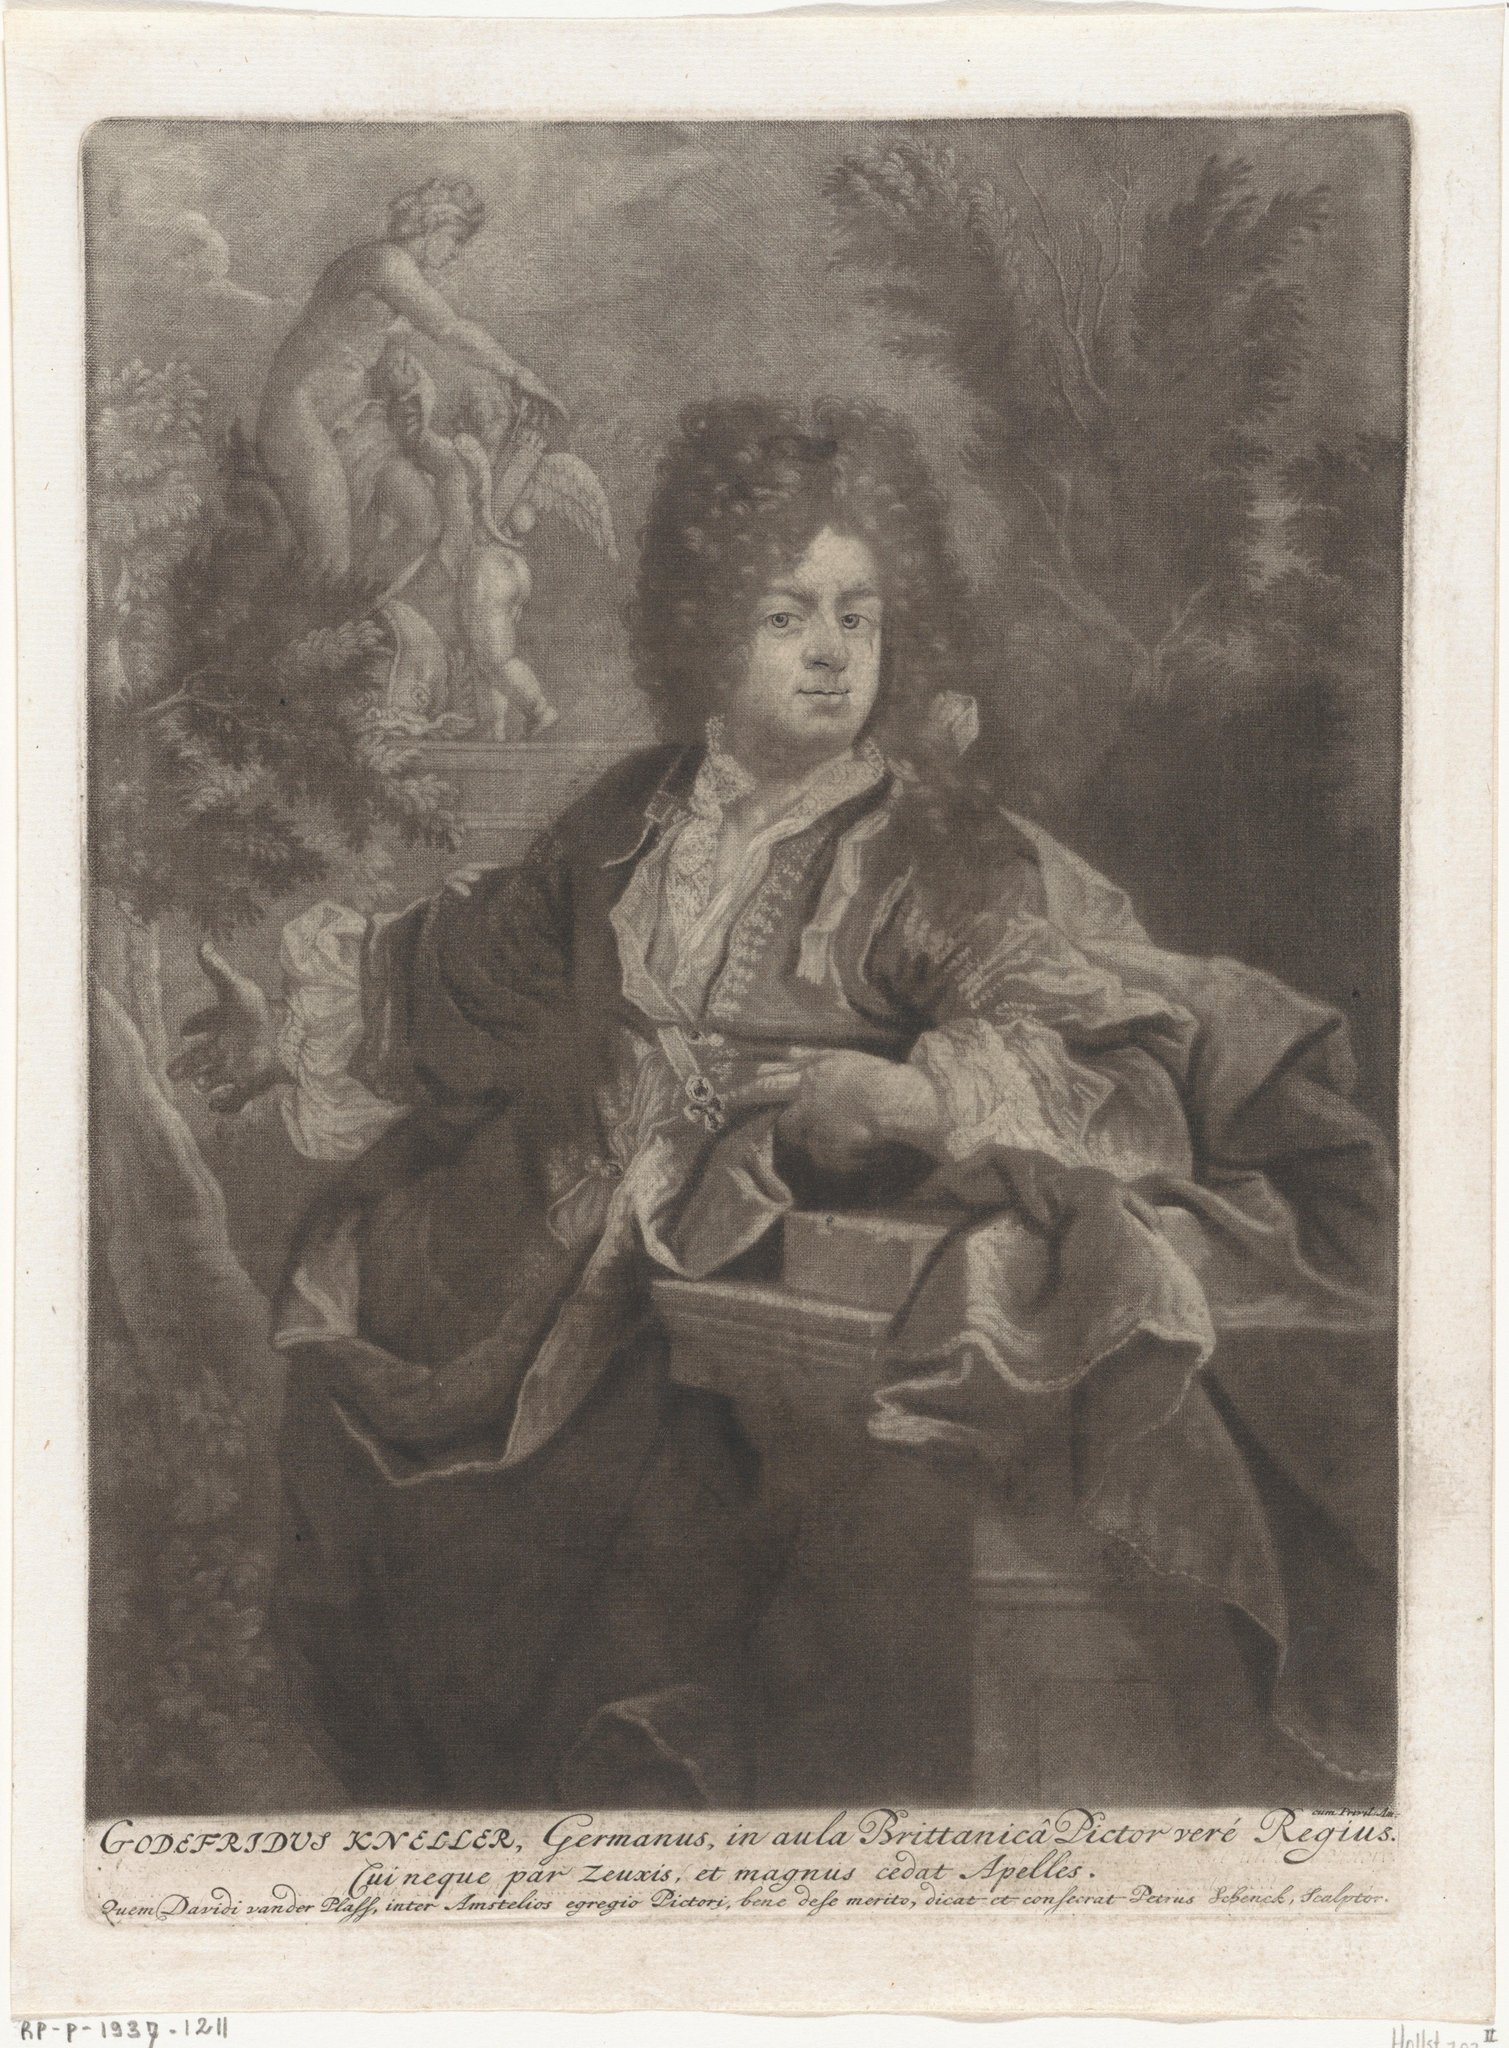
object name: print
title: Portret van Gottfried Kneller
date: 1670-1713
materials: paper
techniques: engraving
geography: amsterdam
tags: london, painter, draughtsman, gottfried kneller, garden, wig, sculpture, venus and cupid (cupid not being mere attribute)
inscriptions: collector's mark: Lugt 2228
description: De tekenaar en schilder Gottfried Kneller staat in een siertuin voor een sculptuur van Venus en Amor.